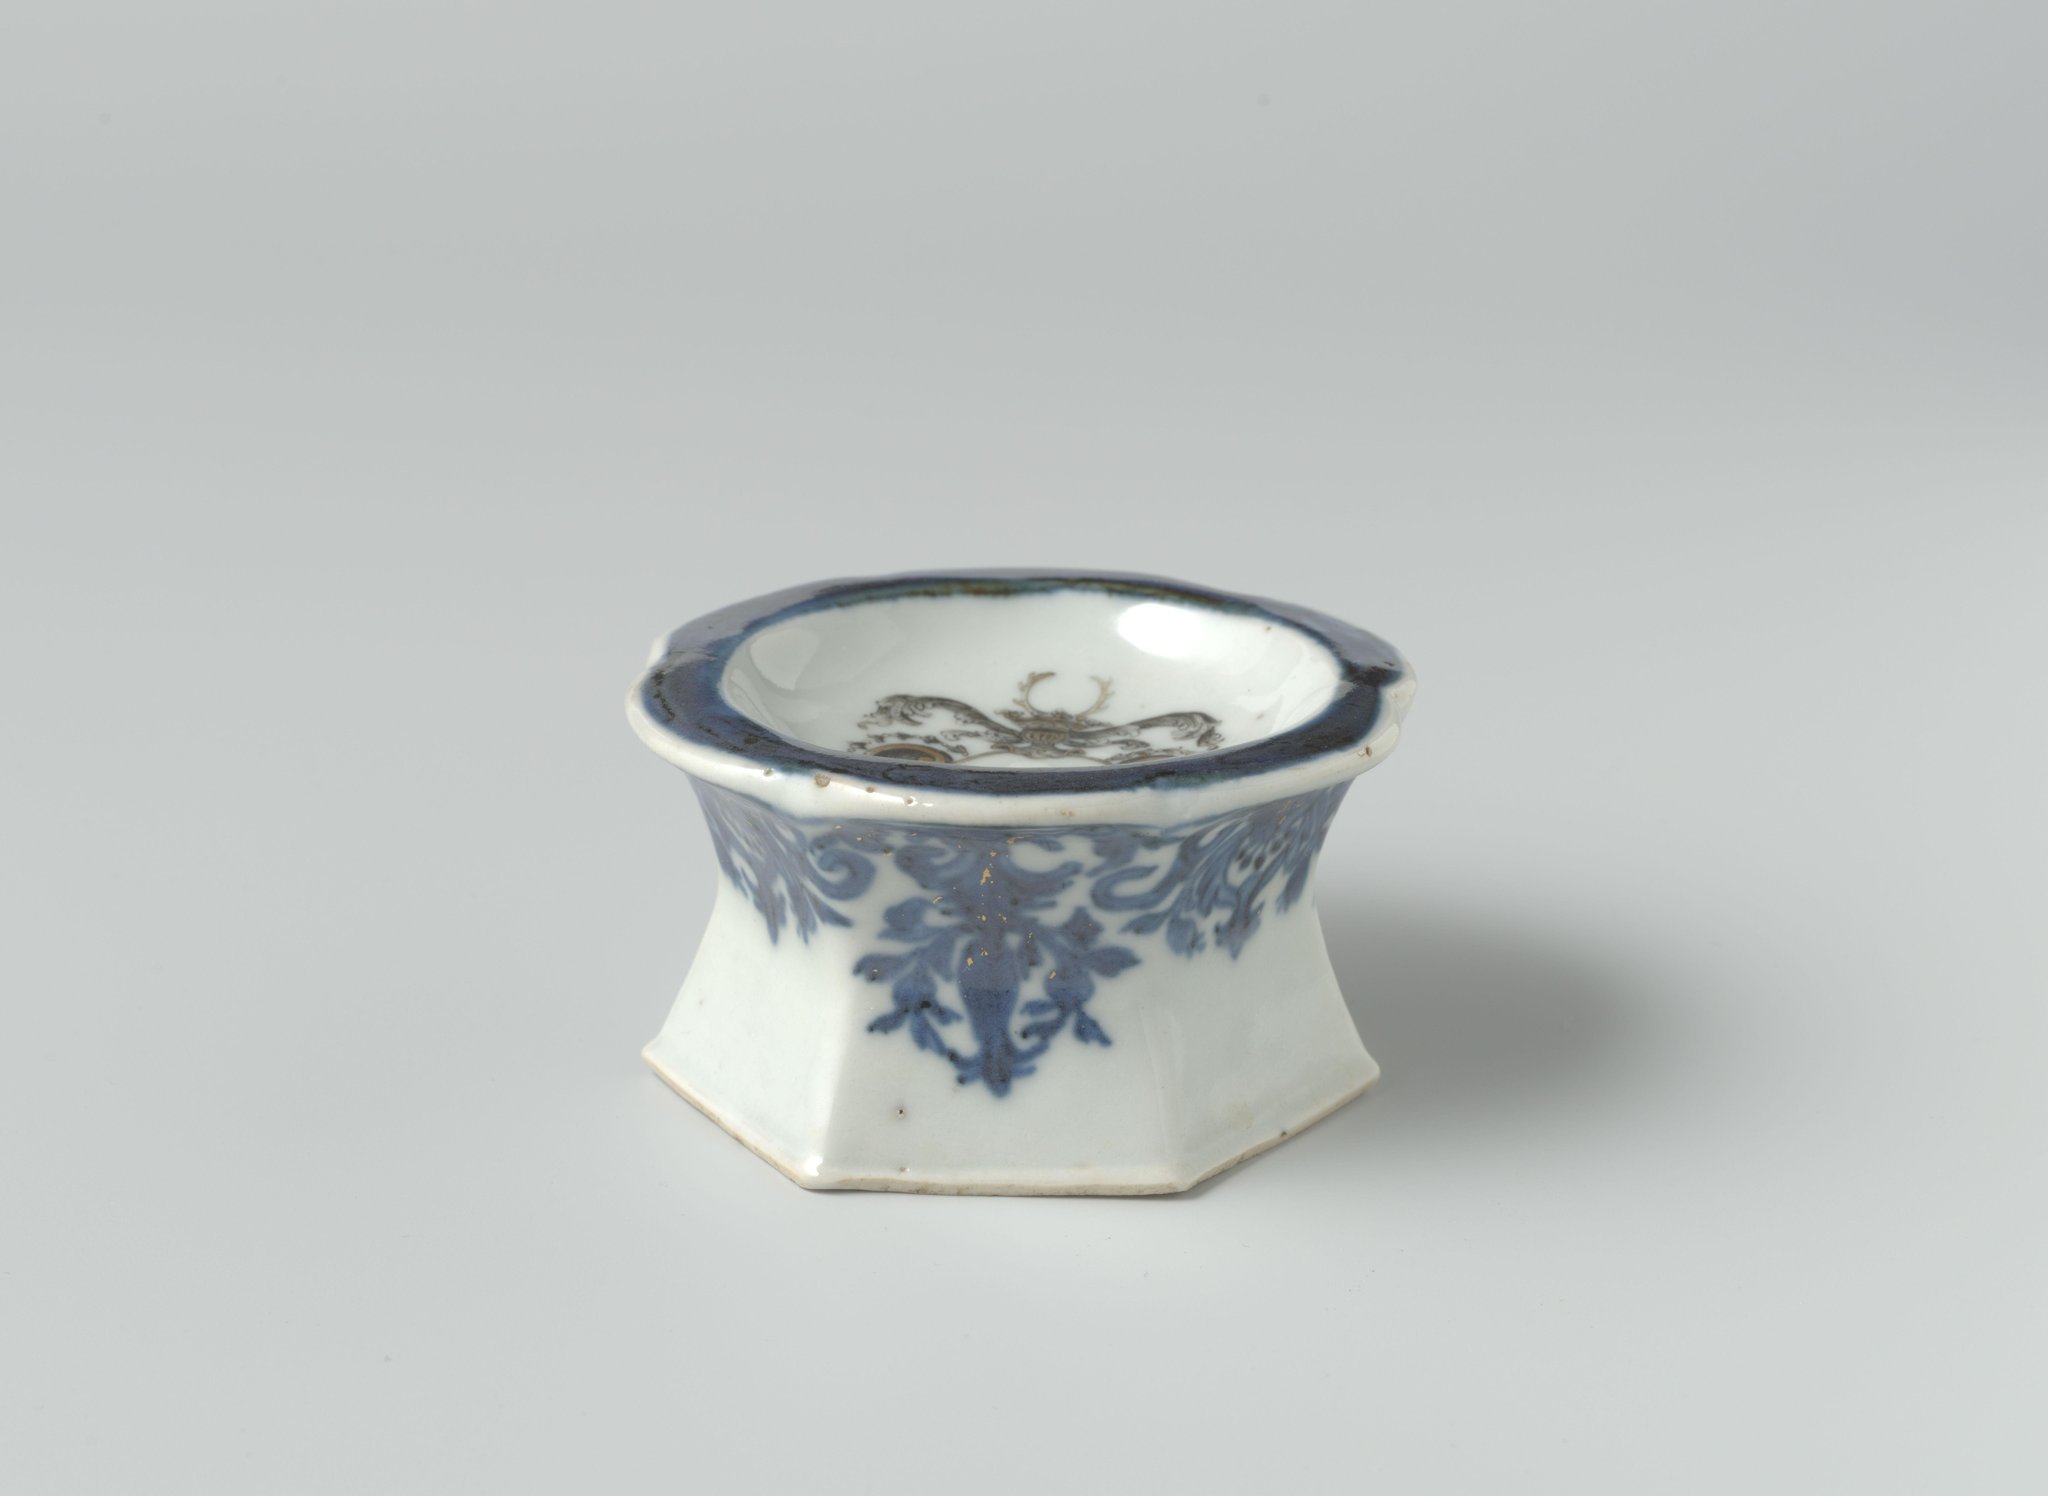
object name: salt condiment vessel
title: Zoutvat met het wapen van de familie Swellengrebel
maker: Anonymous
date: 1740-1750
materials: cobalt, glaze, gold, paint, porcelain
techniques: firing, forming, gilding, turning, vitrification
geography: china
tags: utrecht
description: Zoutvat met een zeshoekige uitlopende voet en een zeslobbige rand. Beschilderd in onderglazuur blauw en met zwart en goud op het glazuur. Aan de buitenzijde een brede band met bandwerk en bloemranken in blauw met goud, rond de rand een blauwe band en in het centrum het wapen van de familie Swellengrebel in zwart en goud: Franse lelie op een ovaal schild en een gewei boven een kroon als helmteken. Wapenporselein in blauw-wit en emailkleuren.